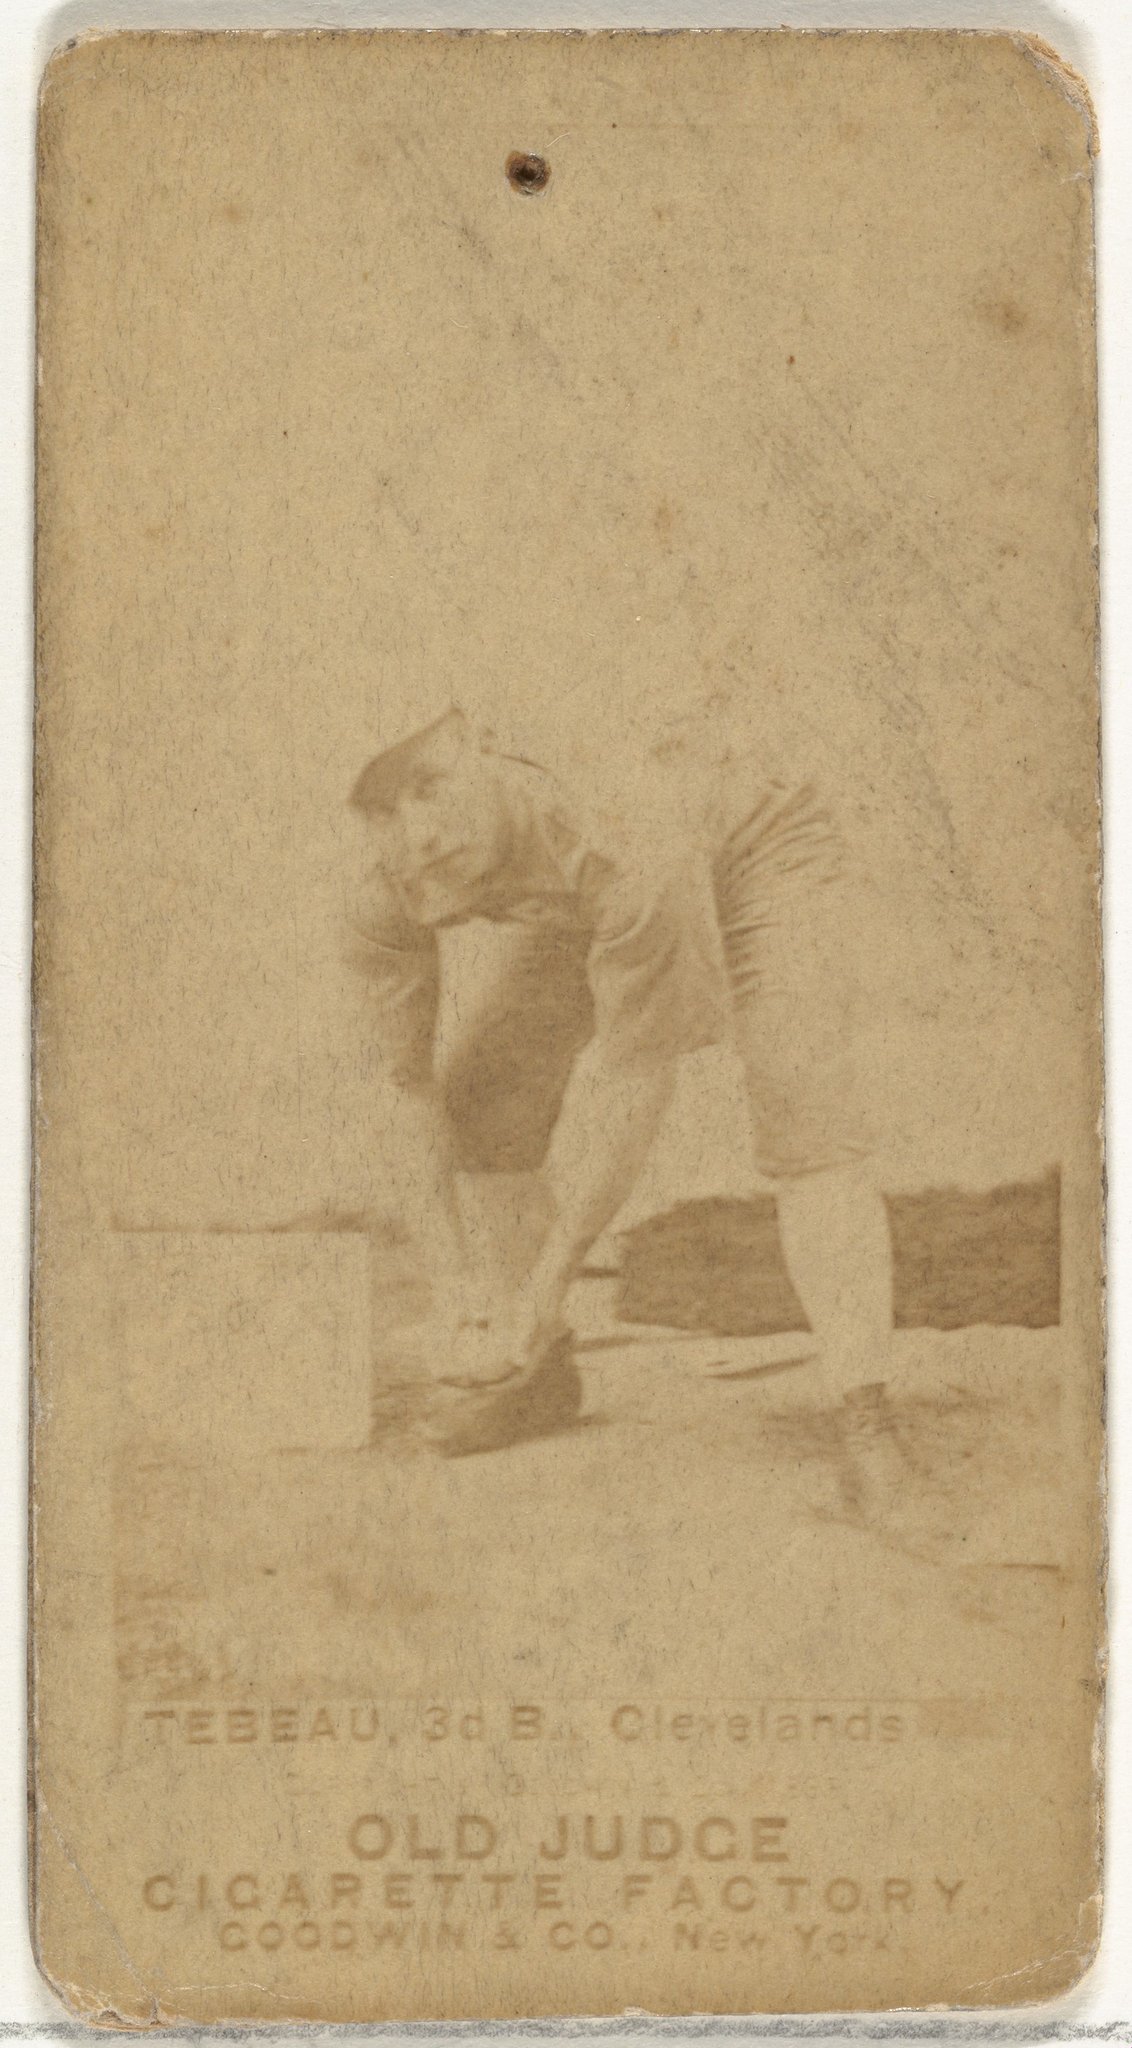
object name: baseball card, photograph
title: Oliver Wendell "Patsy" Tebeau, 3rd Base, Cleveland, from the Old Judge series (N172) for Old Judge Cigarettes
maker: goodwin & company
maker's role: publisher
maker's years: 1850-1950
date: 1887-1890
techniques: albumen silver print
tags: men,portraits,baseball,athletes